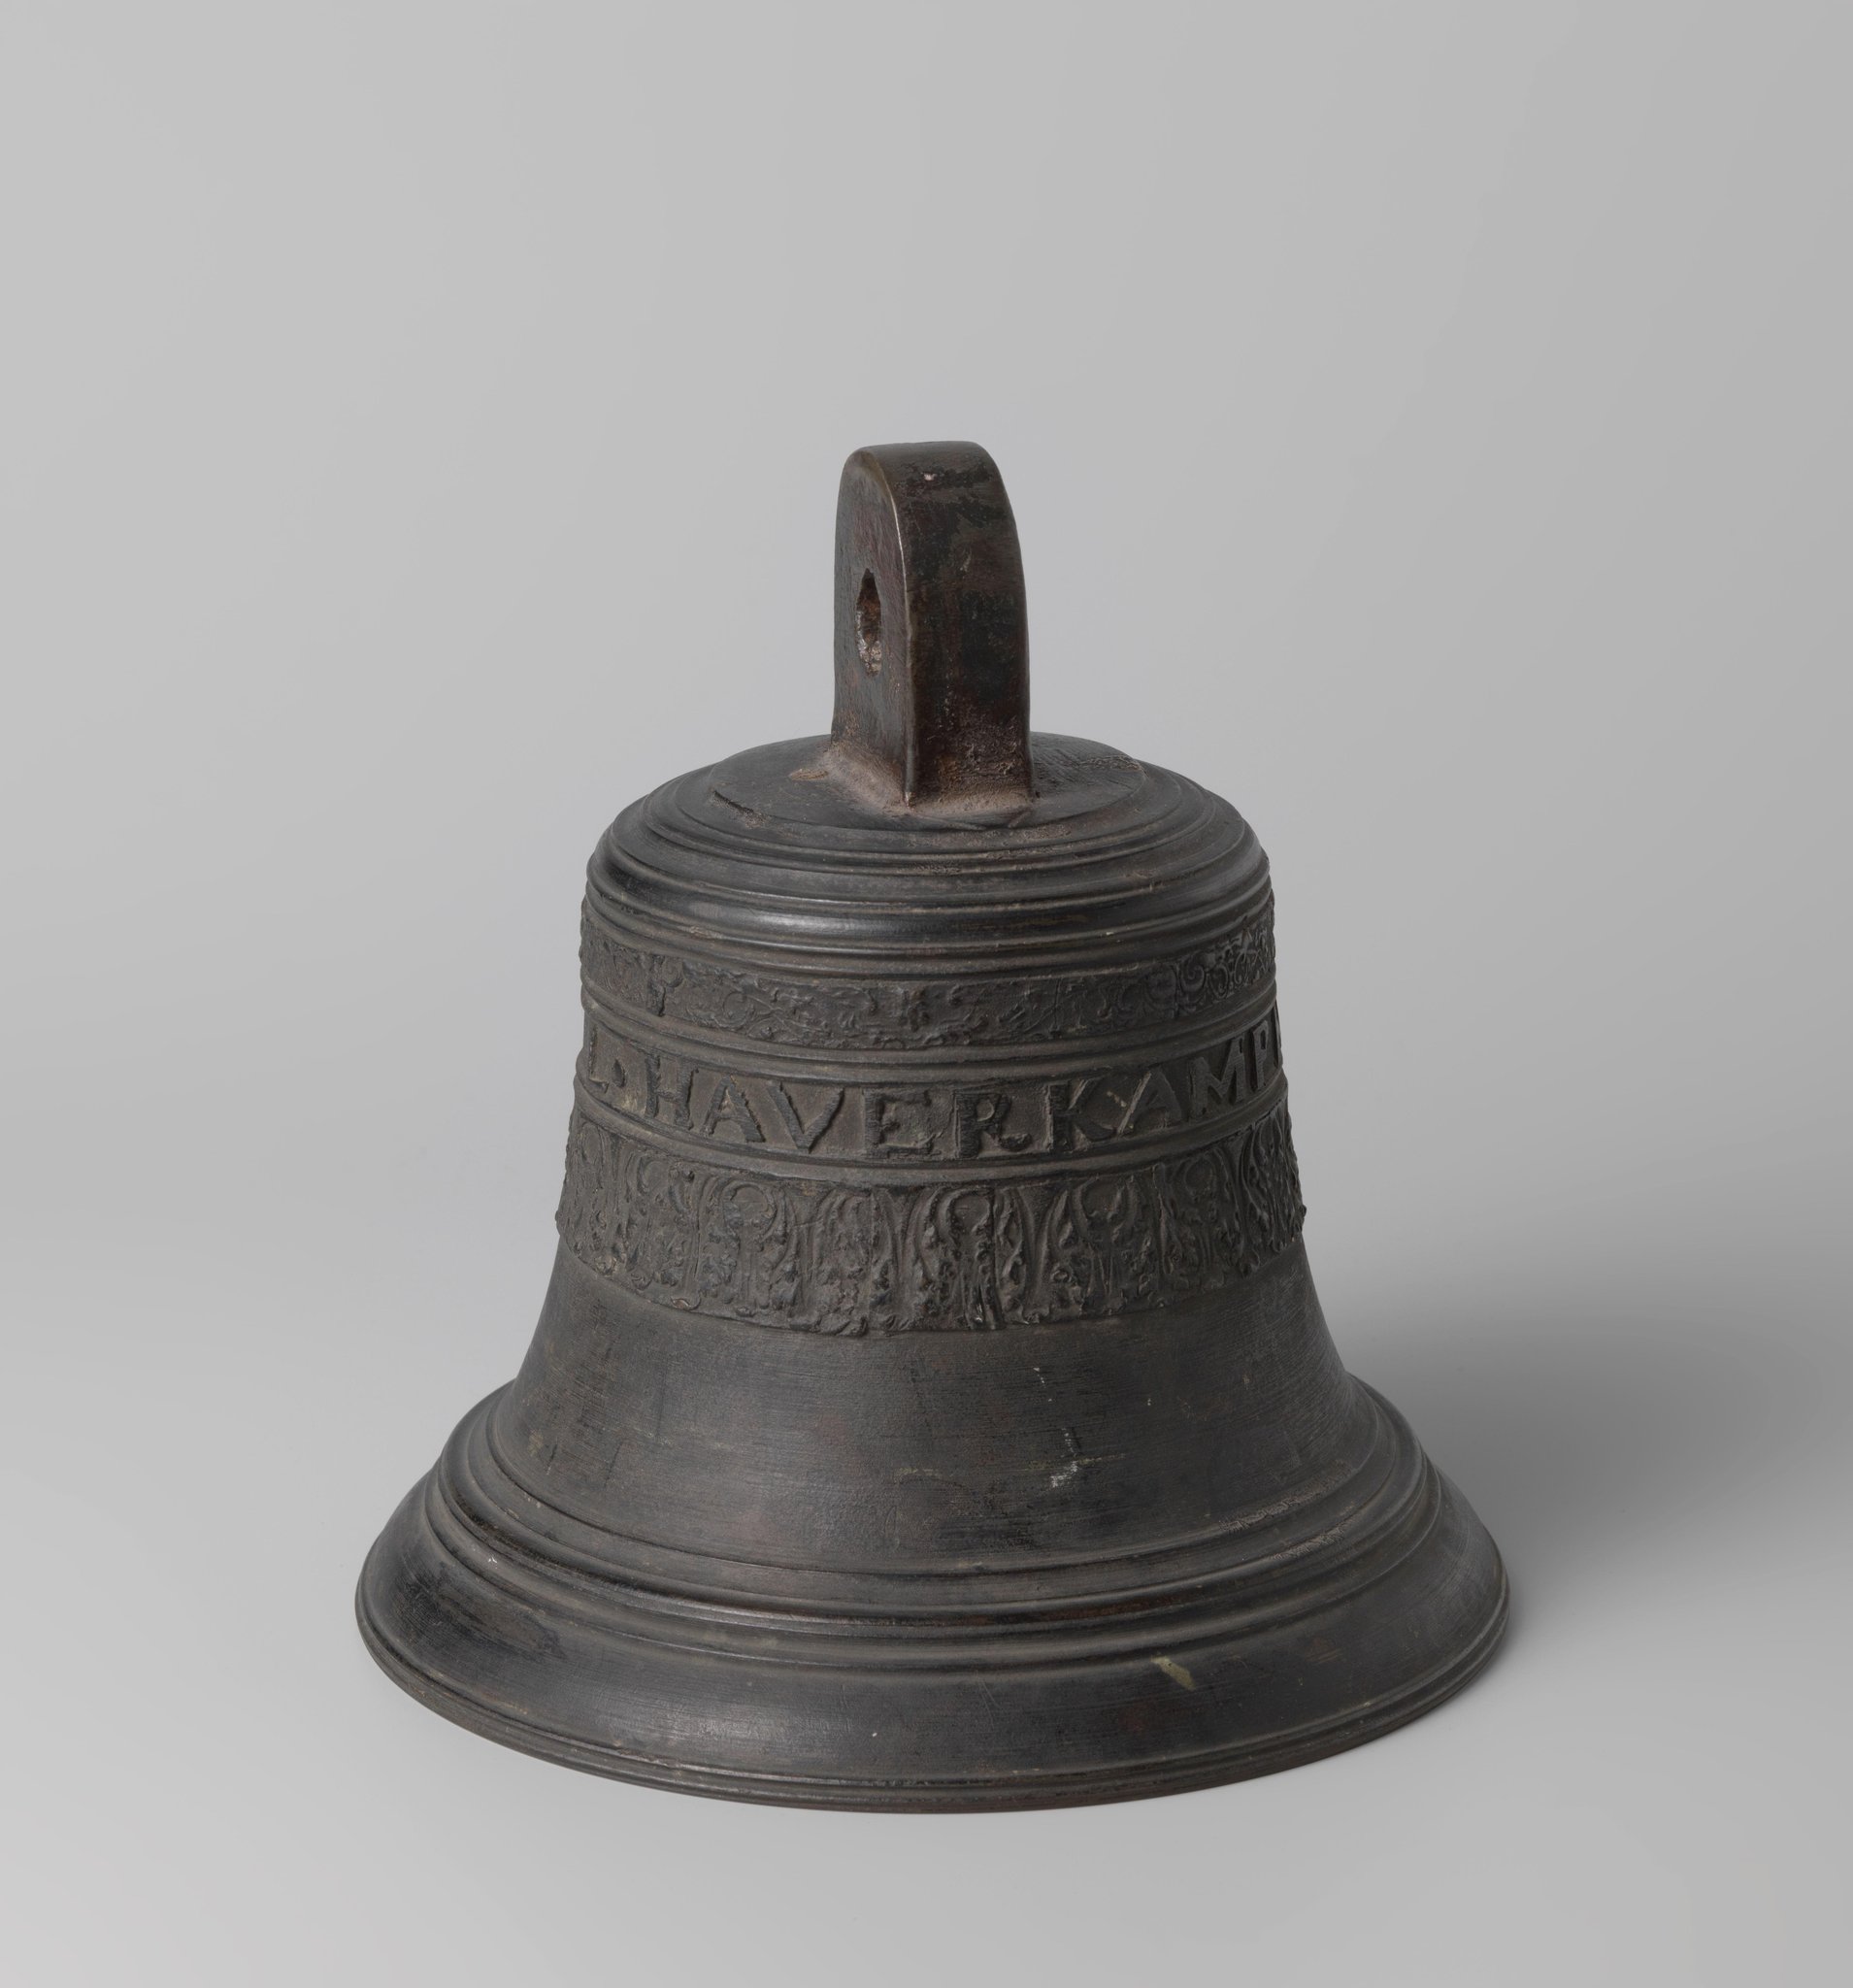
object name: percussion instrument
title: Bell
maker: l. haverkamp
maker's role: bellfounder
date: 1781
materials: bronze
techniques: casting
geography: hoorn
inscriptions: inscription: ‘L.HAVERKAMP M.F. HORNAE Ao 1781’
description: Bronzen luidklok. Bovenaan een geprofileerd fries met opschrift in Latijnse majuskels: L.HAVERKAMP M.F. HORNAE Ao 1781. Boven het opschrift een fries bestaande uit rankenwerk. Onder het opschrift eveneens een fries met rankenwerk. Met ronde opening aan de bovenzijde.